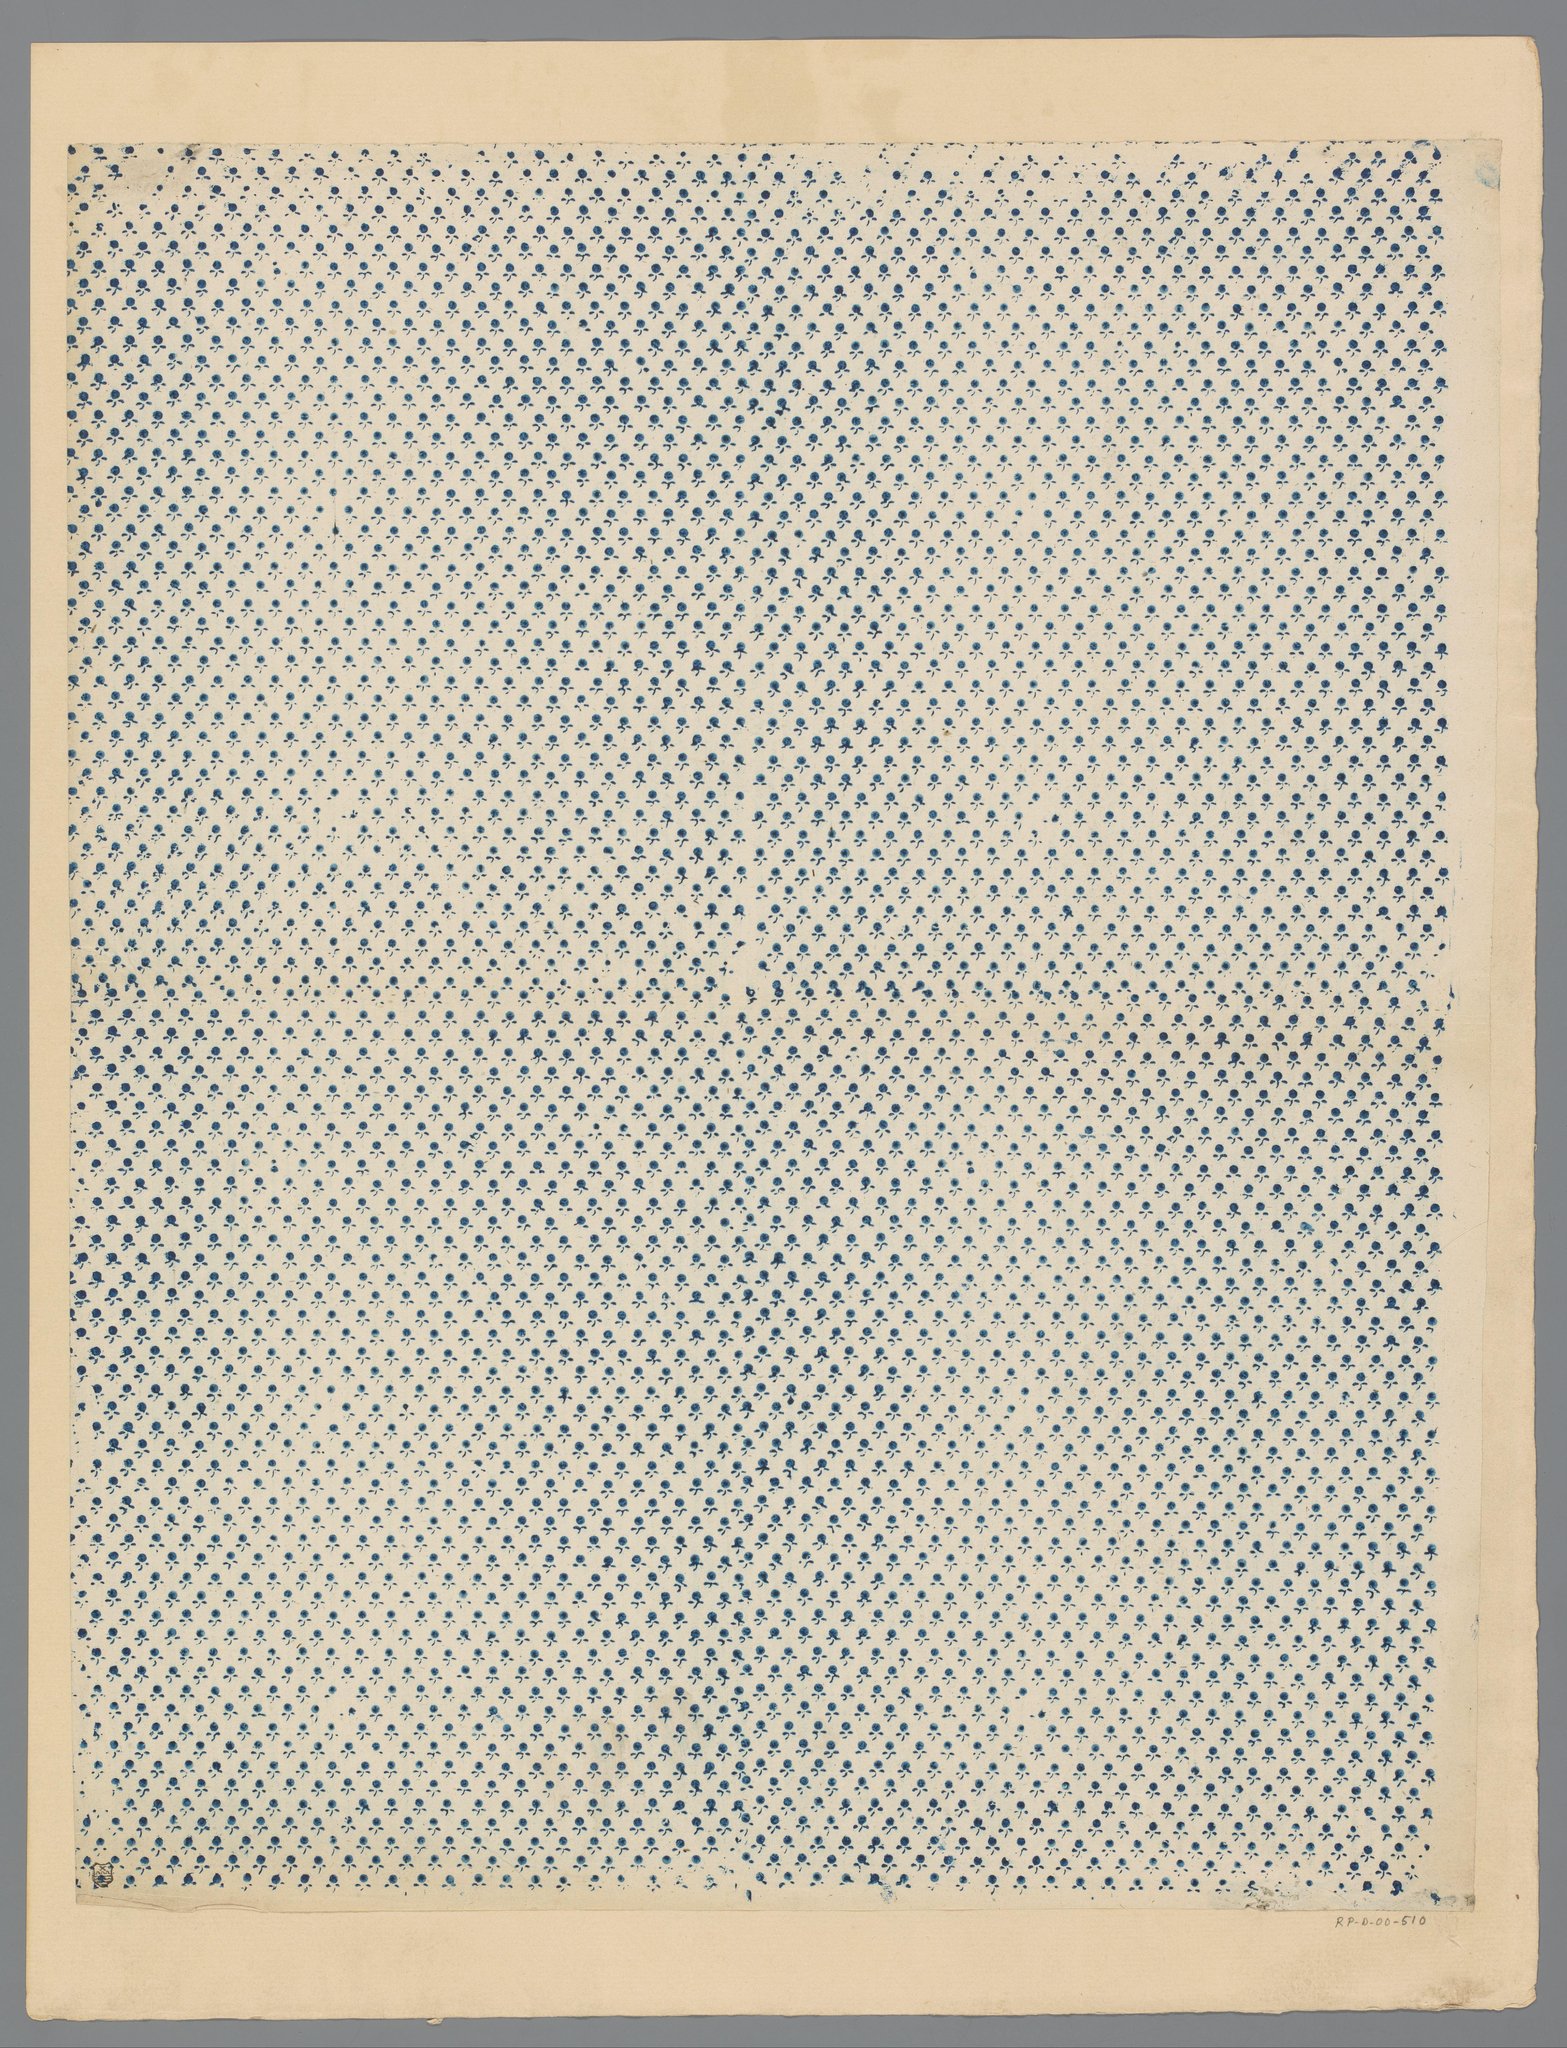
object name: printed paper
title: Blad met strooipatroon van vruchtjesmotief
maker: Anonymous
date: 1800-1900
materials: paper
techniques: printing block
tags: ornament derived from plant forms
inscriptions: collector's mark: Lugt 2760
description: Blad met regelmatig strooipatroon van vruchtjesmotief.